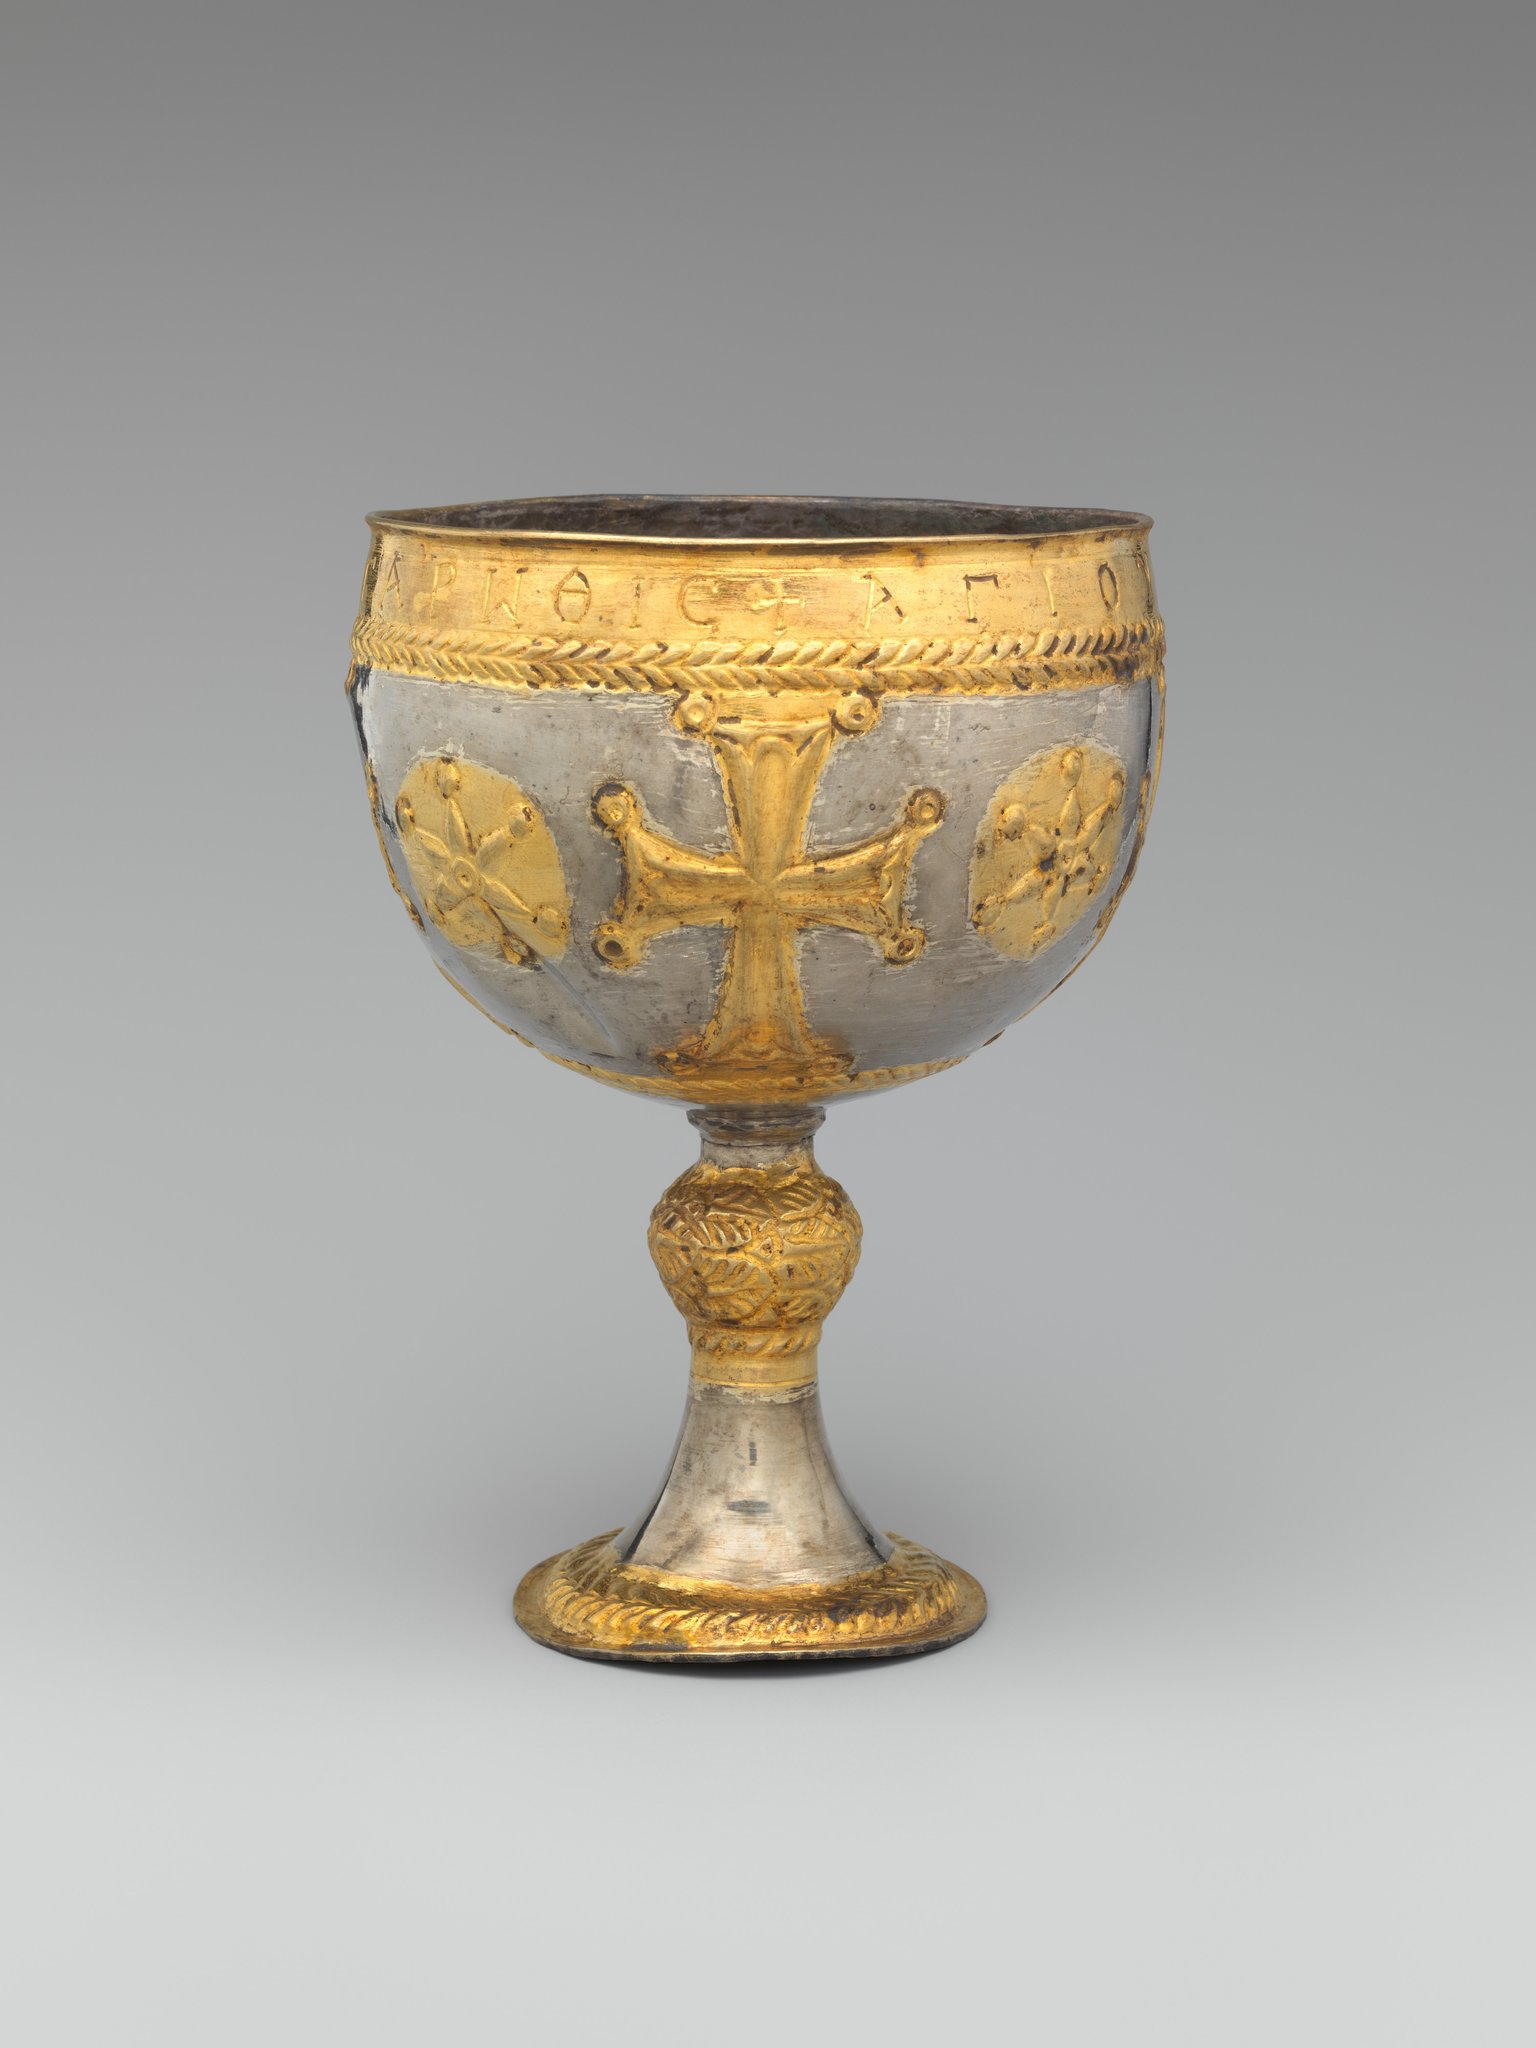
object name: chalice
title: The Attarouthi Treasure - Chalice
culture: byzantine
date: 500-650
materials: gilt silver, silver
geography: syria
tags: stars,cross